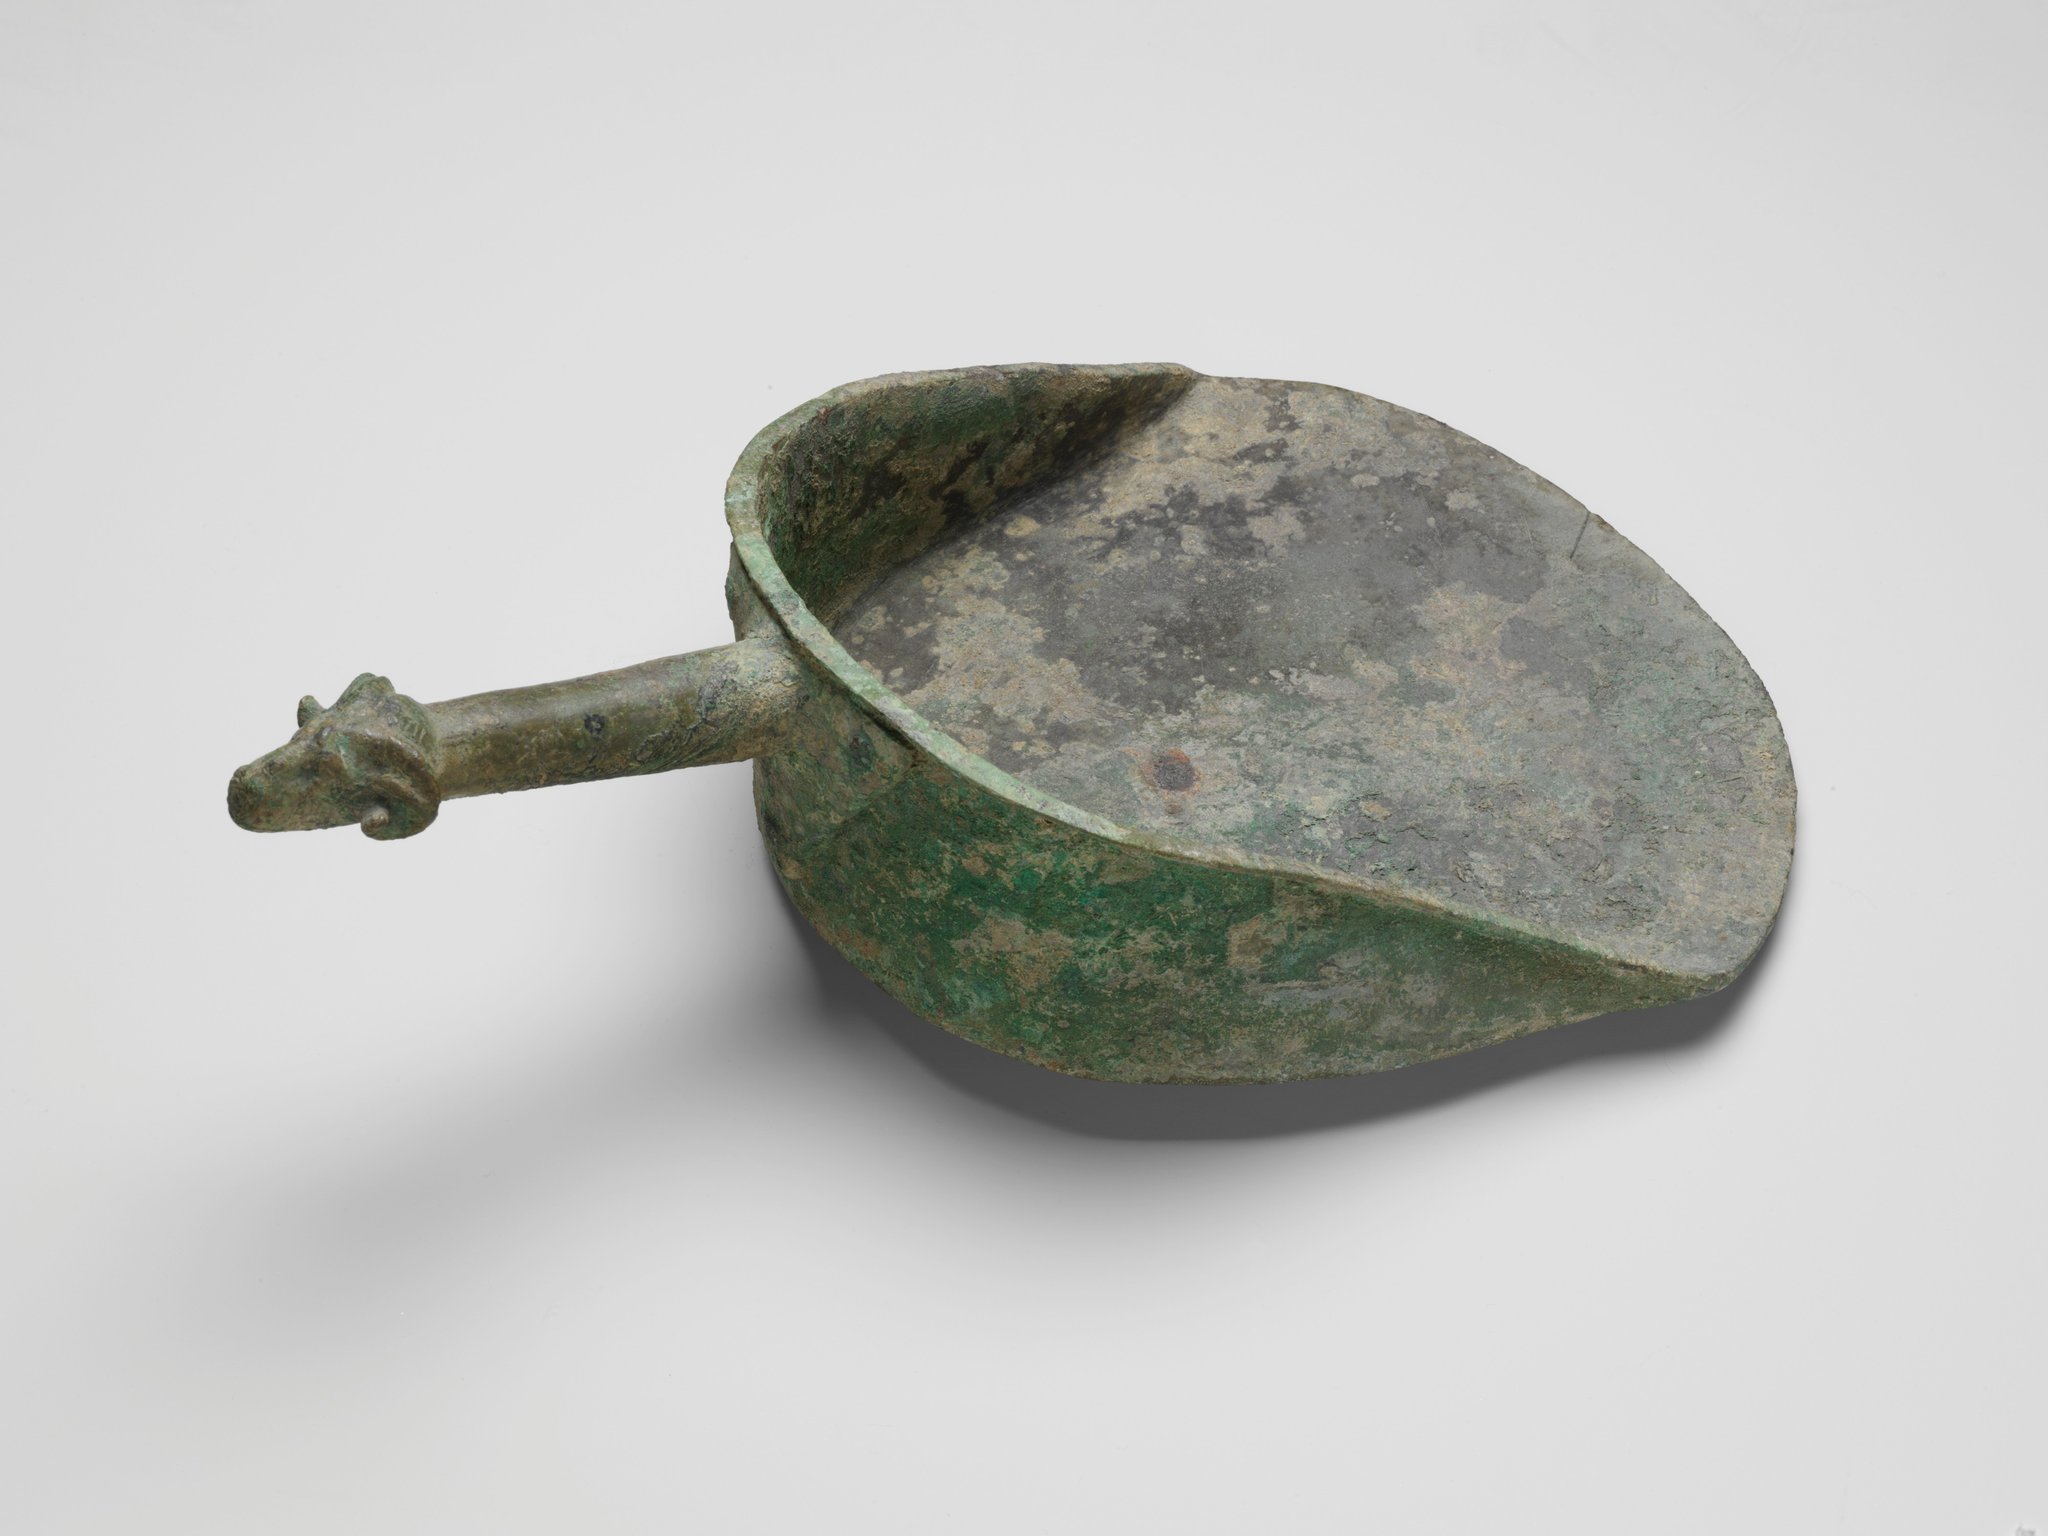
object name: shovel ending in ram's head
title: Bronze shovel with a handle terminating in a ram's head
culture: roman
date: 1-200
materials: bronze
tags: rams